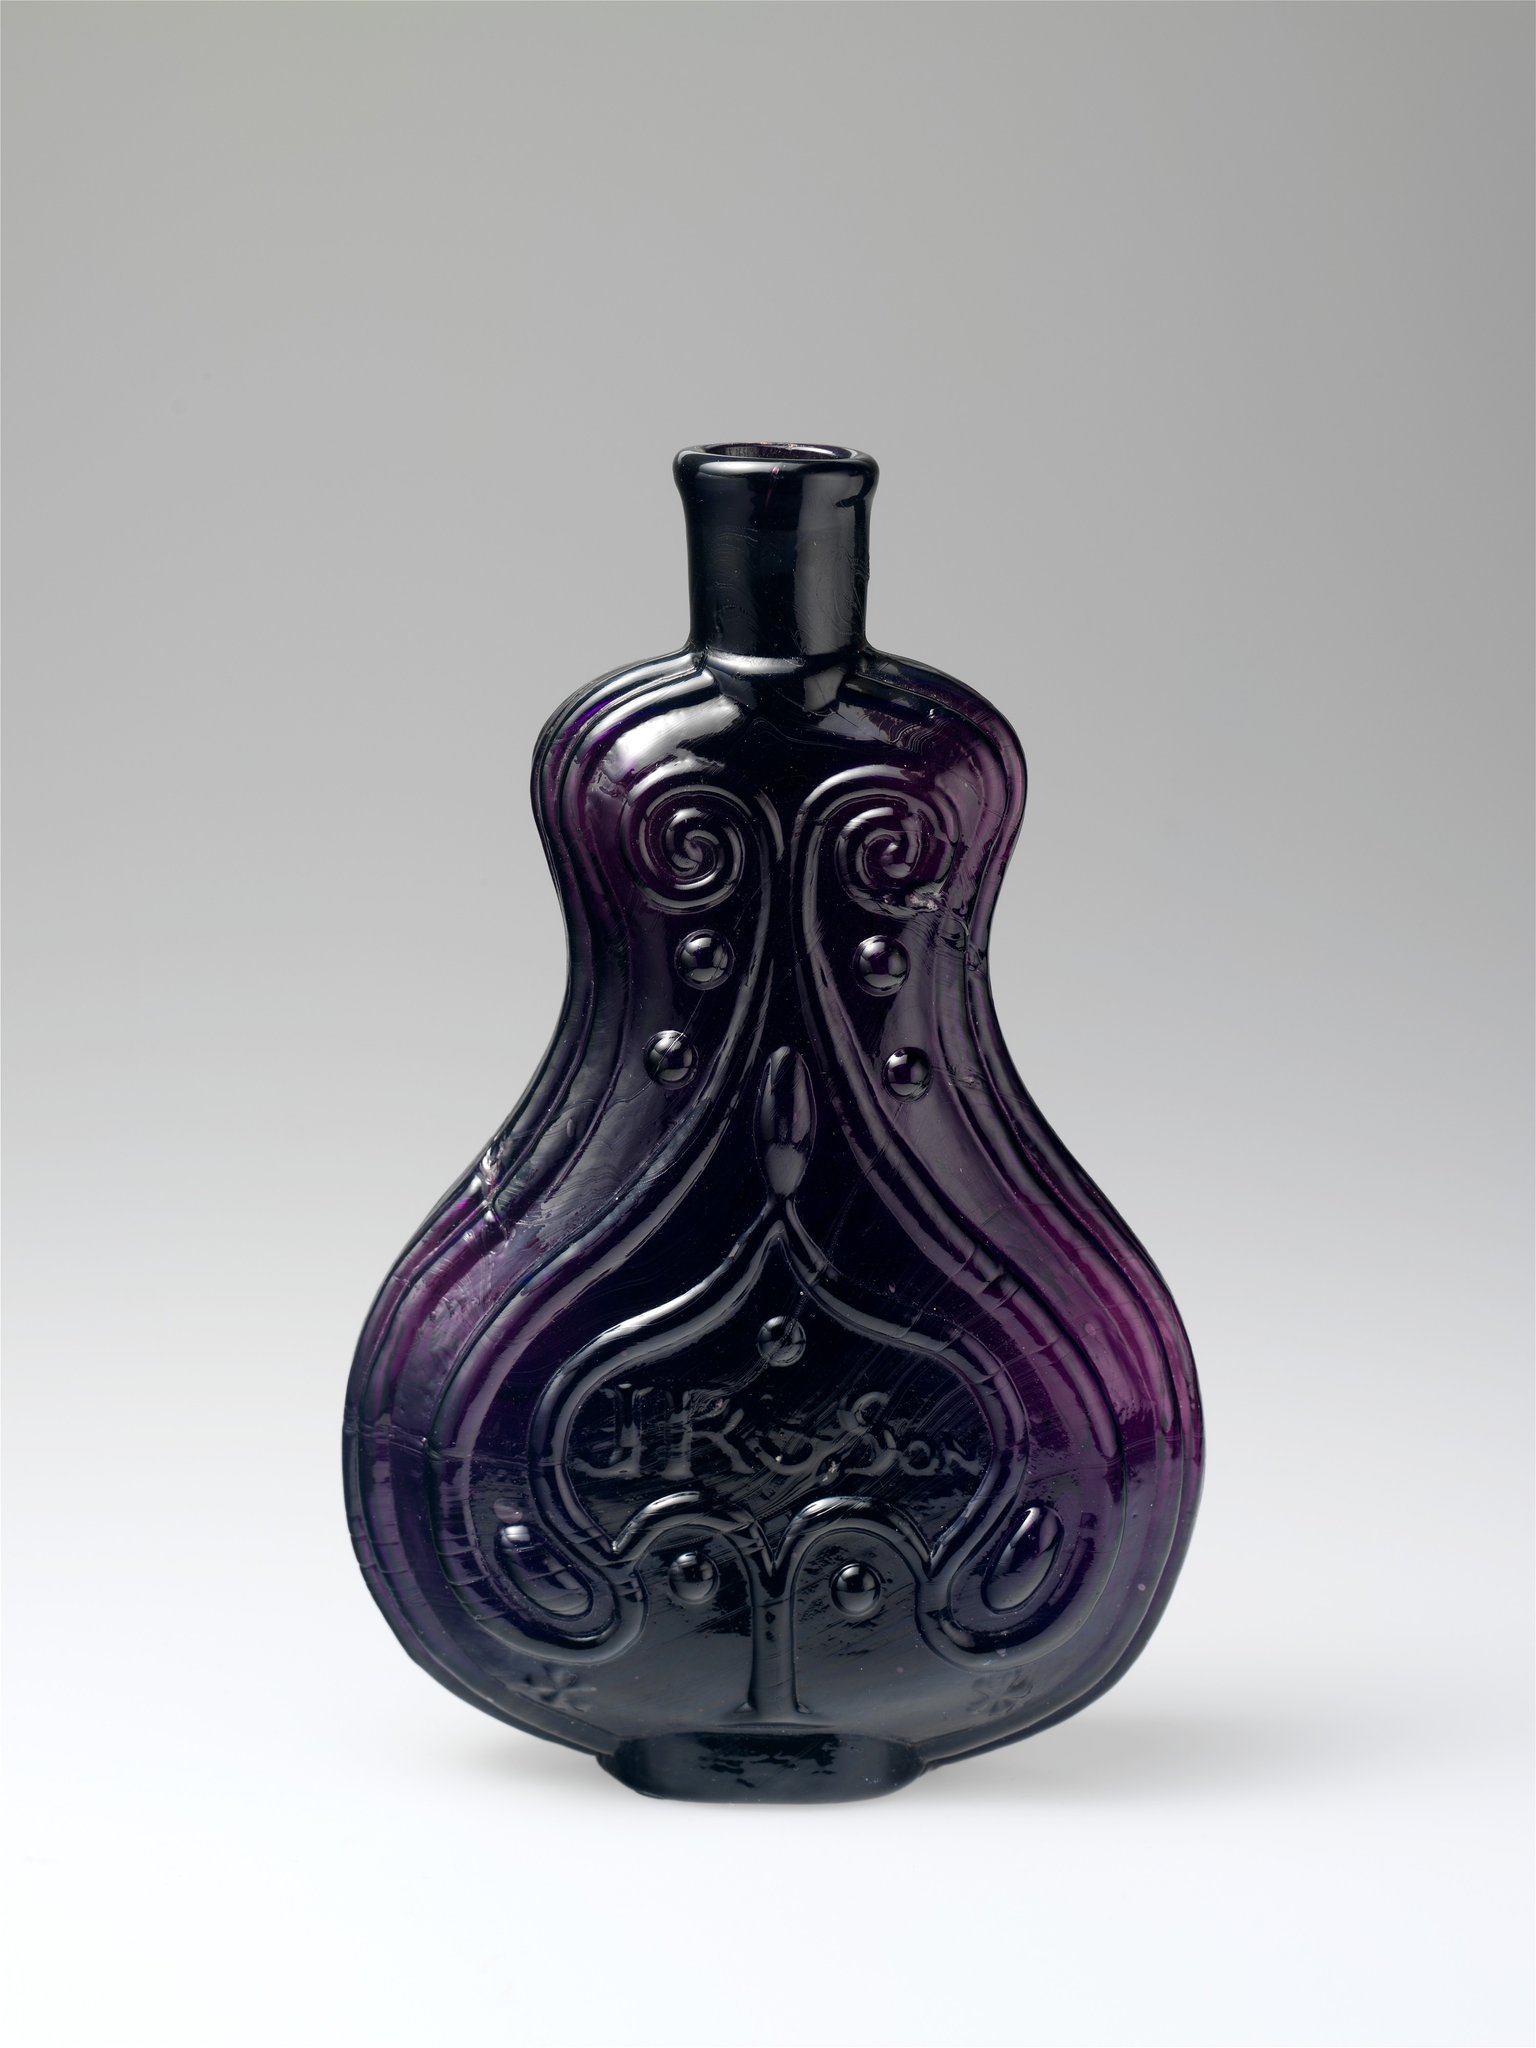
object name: flask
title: Figured flask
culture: american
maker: j. r. robinson and sons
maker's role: manufacturer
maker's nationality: american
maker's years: 1823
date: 1830-1835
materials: glass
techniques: glassblowing, molding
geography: united states